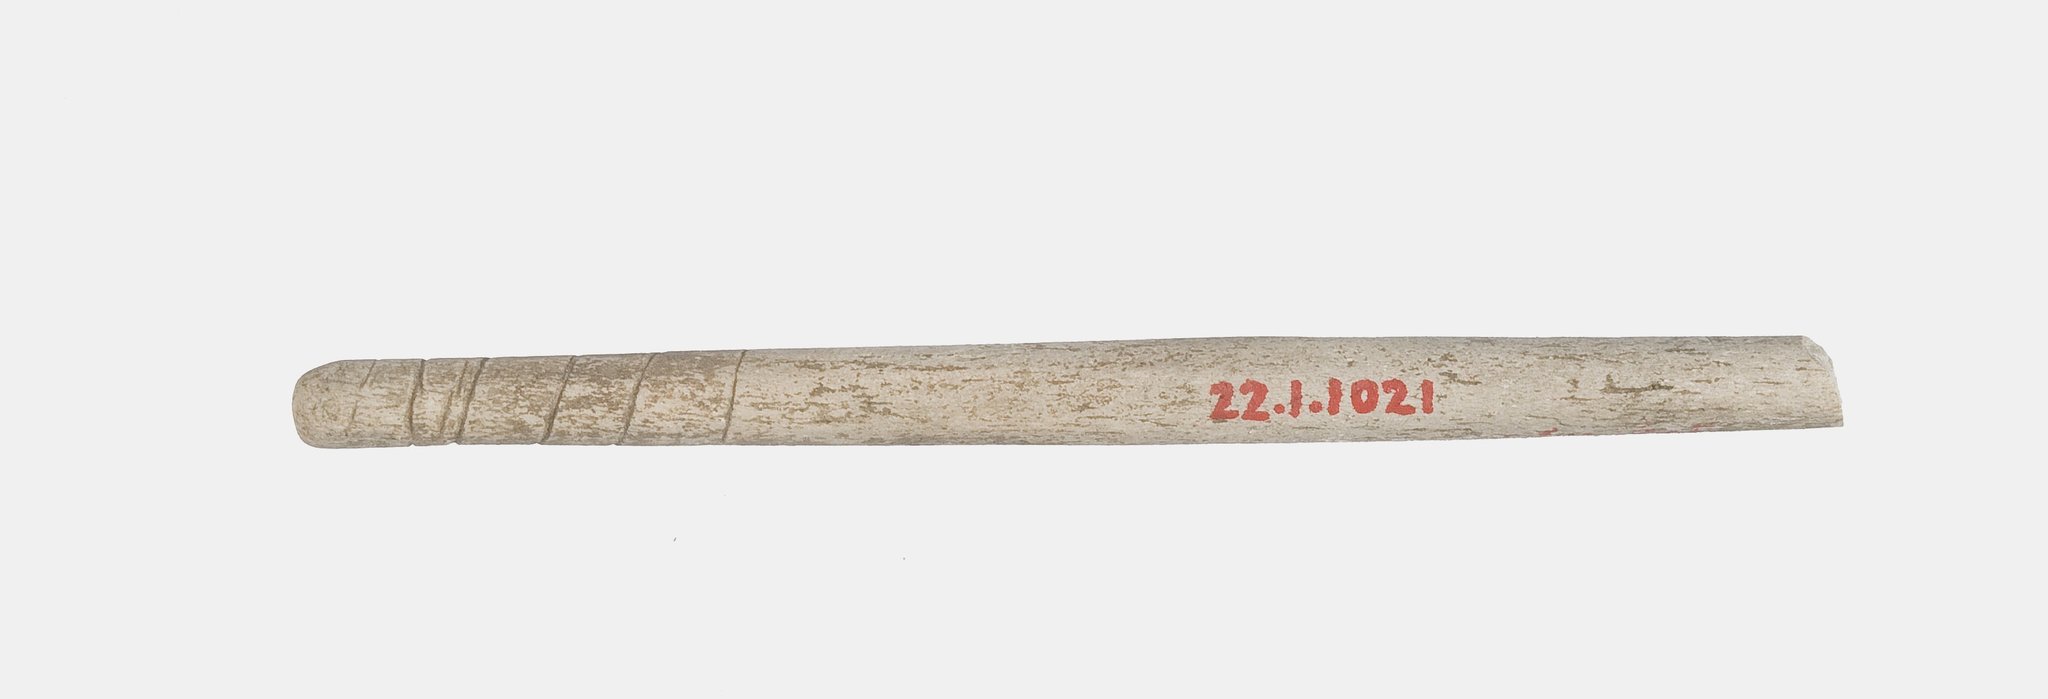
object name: pin beater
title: Weaving tool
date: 1295-1070 BCE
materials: bone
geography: egypt